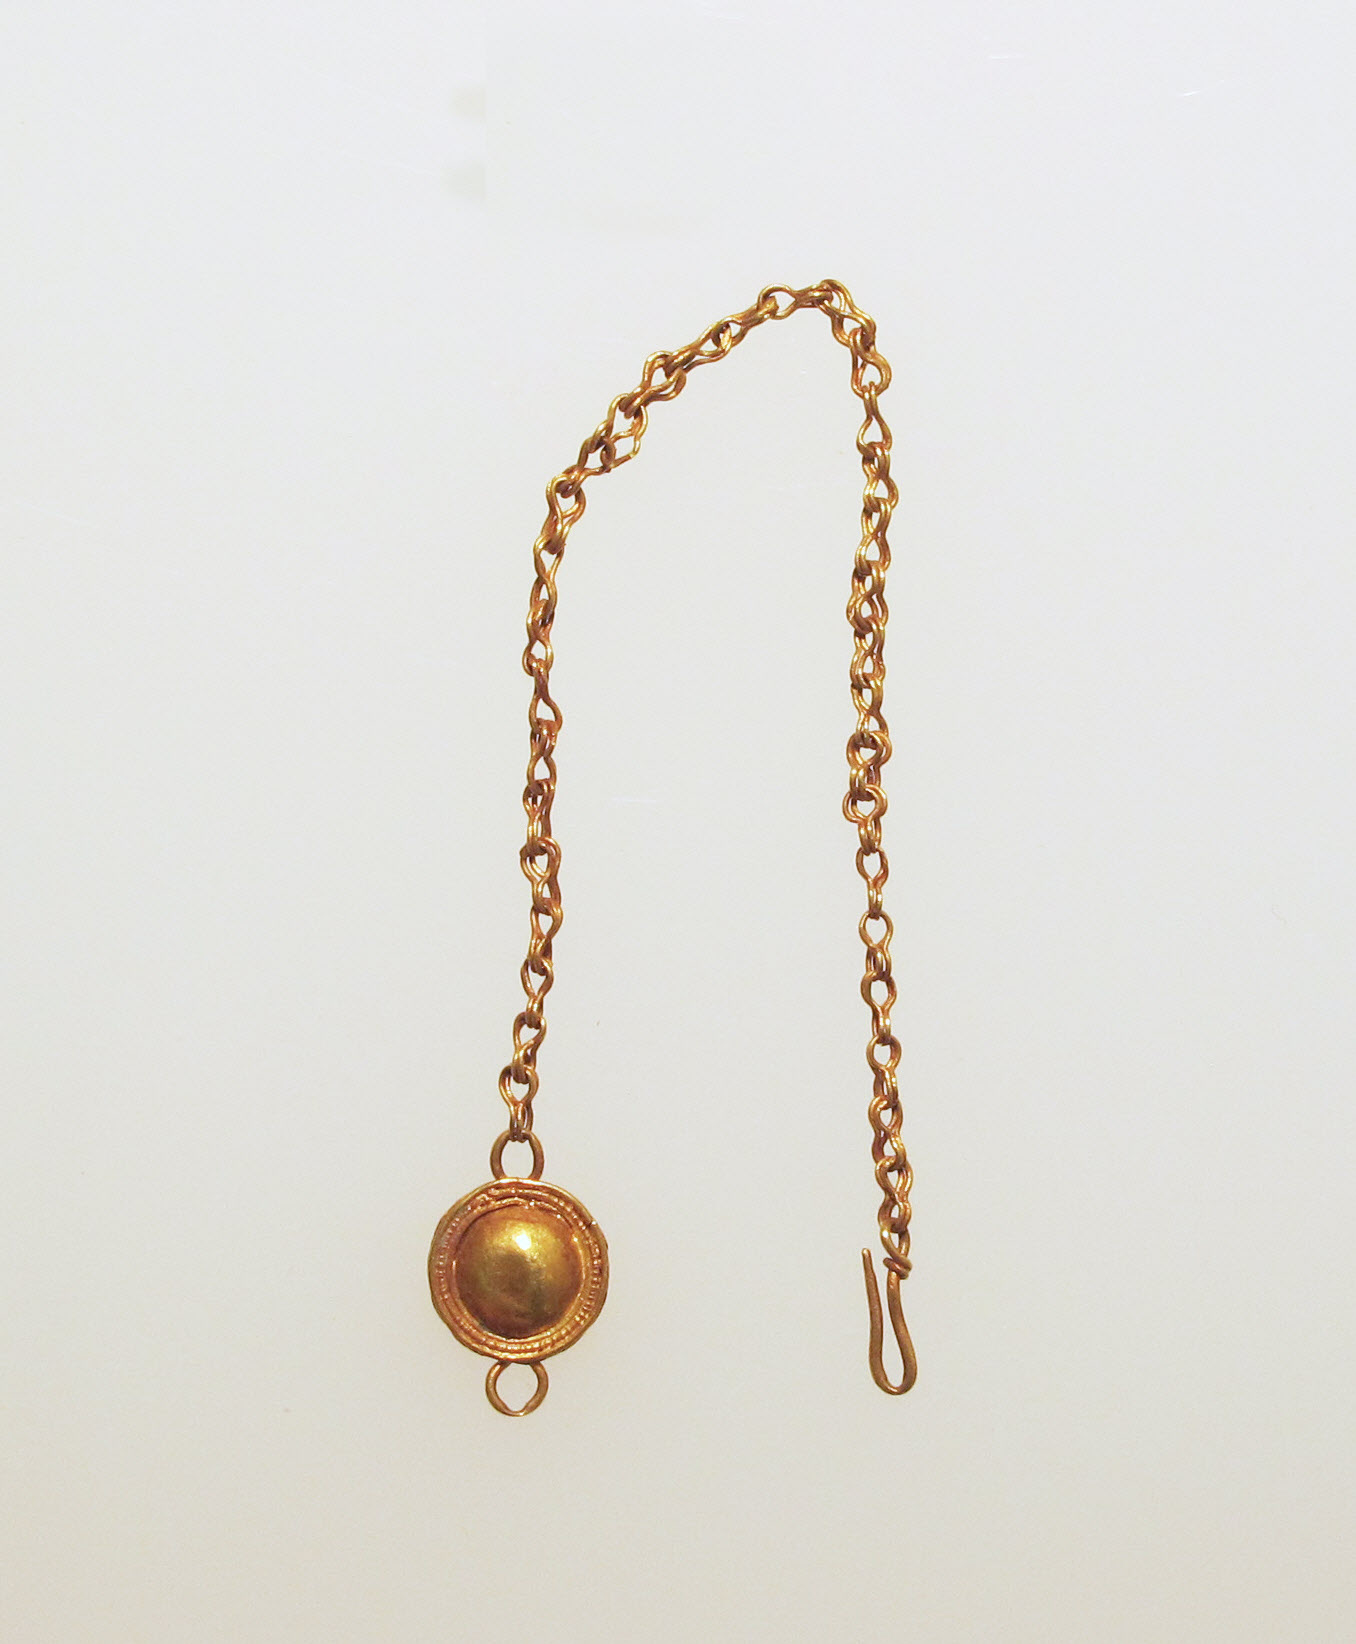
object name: earring, chain type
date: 7000 BCE-330 CE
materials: gold